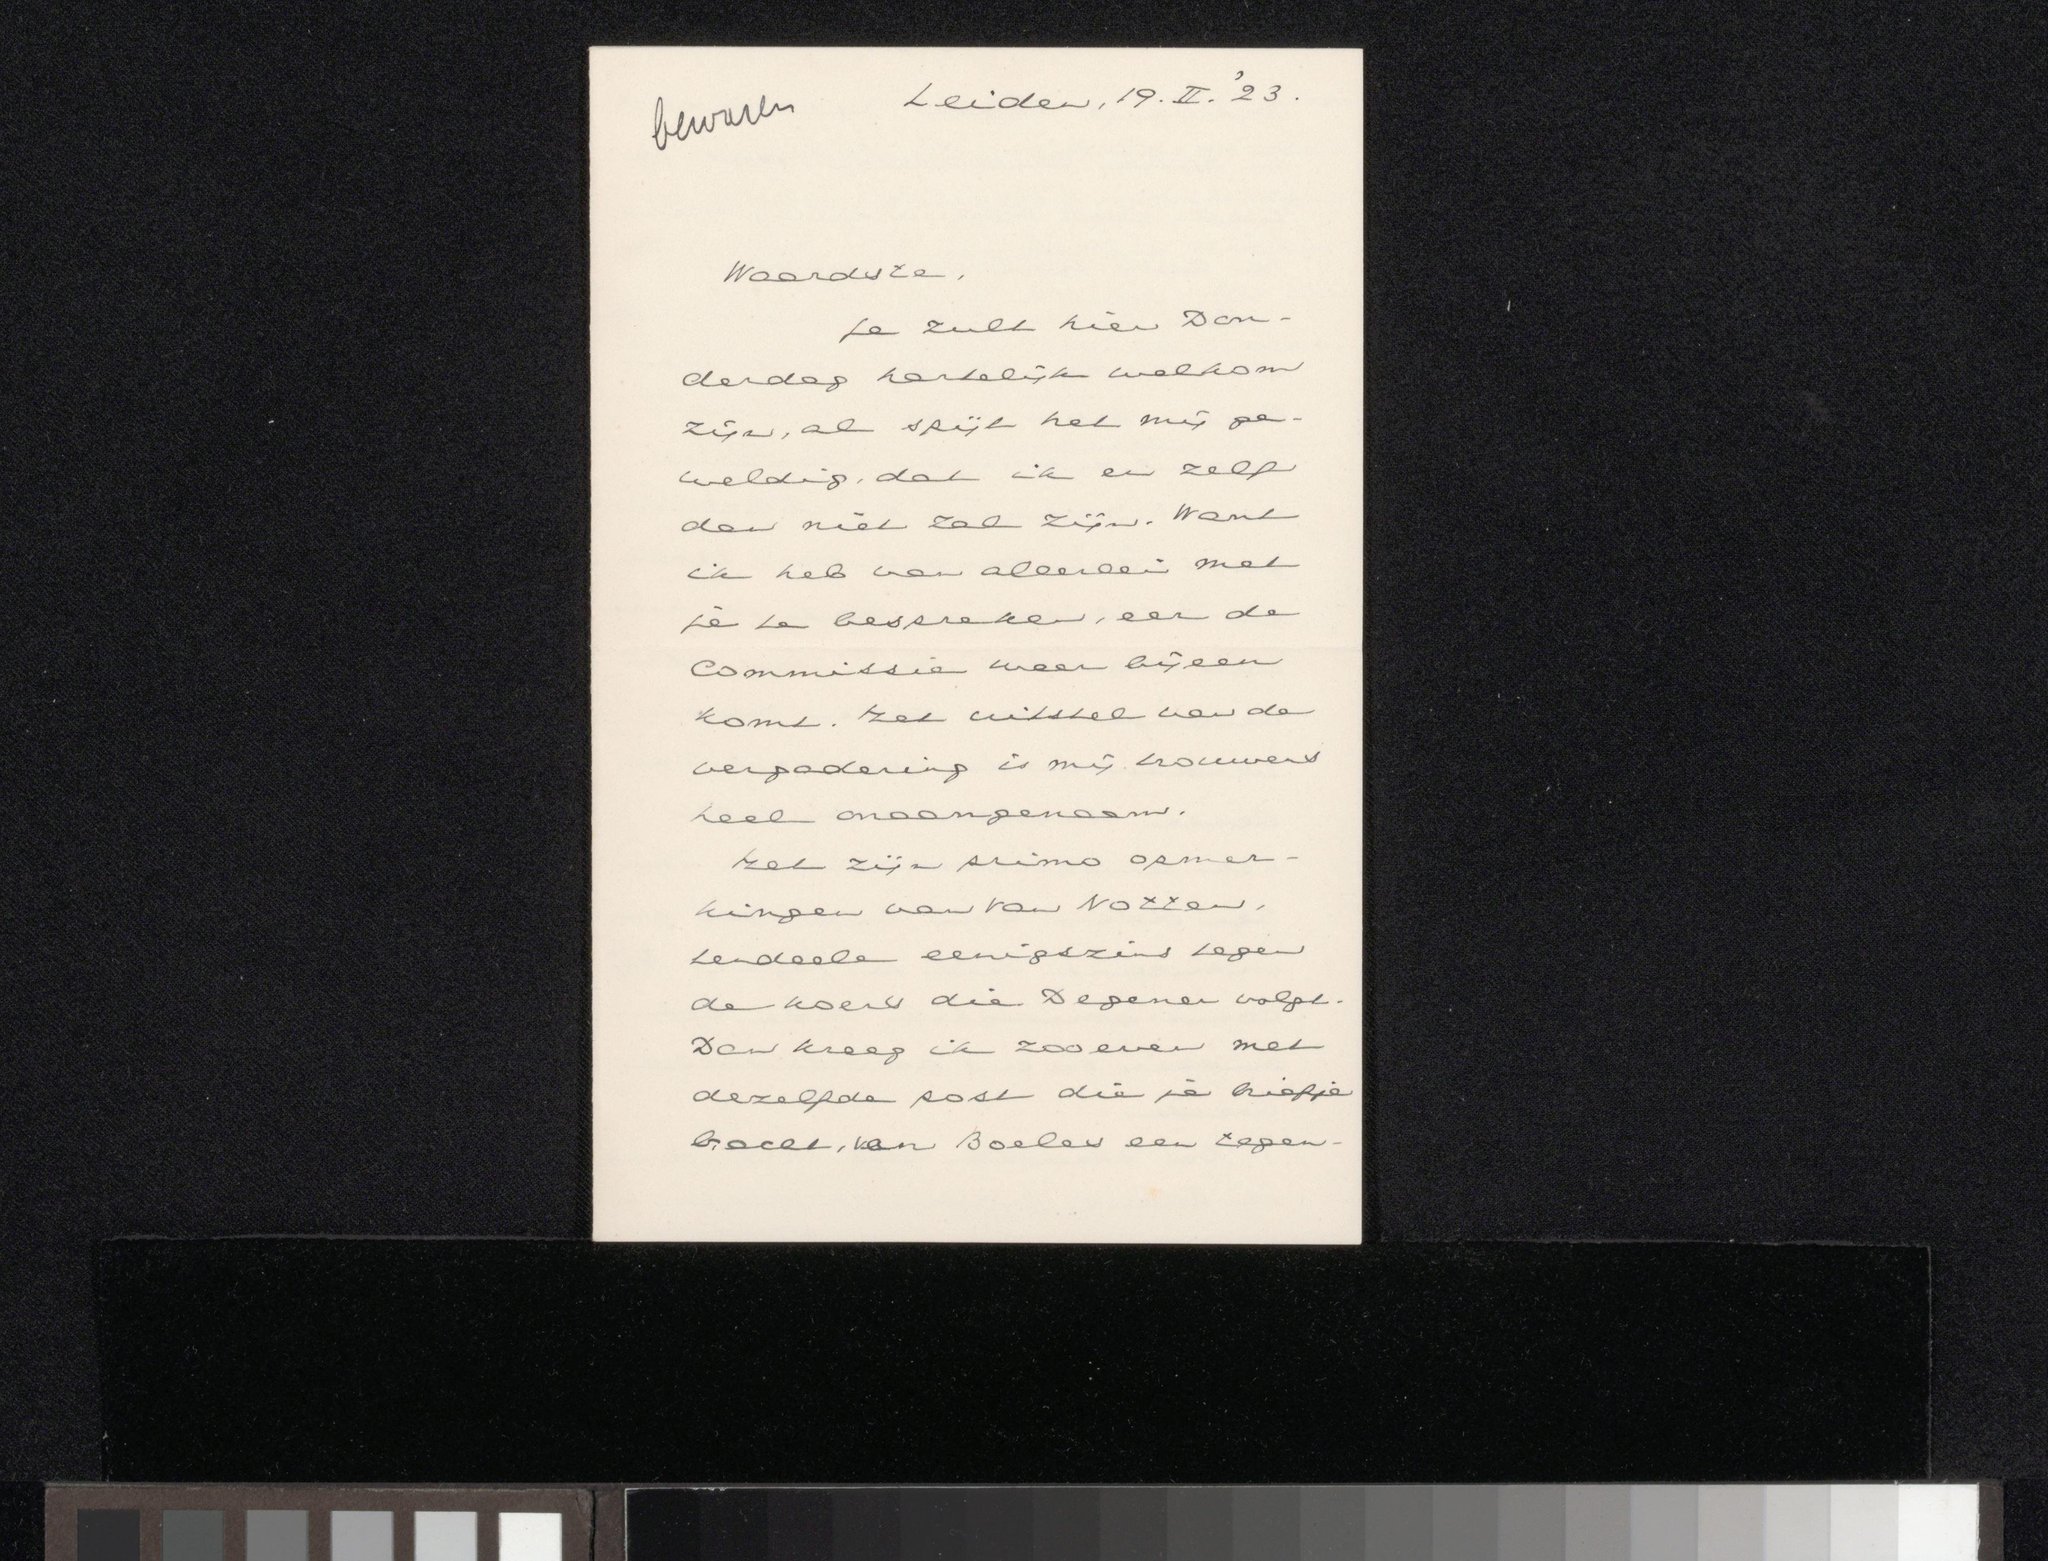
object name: letter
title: Brief aan Jan Veth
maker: johan huizinga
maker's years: 1872-1945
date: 1923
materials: ink, paper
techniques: pen, writing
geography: leiden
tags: painter, print maker, draughtsman, jan veth, rotterdam, frederik schmidt-degener, nijmegen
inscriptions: collector's mark: ‘RPK’, watermark